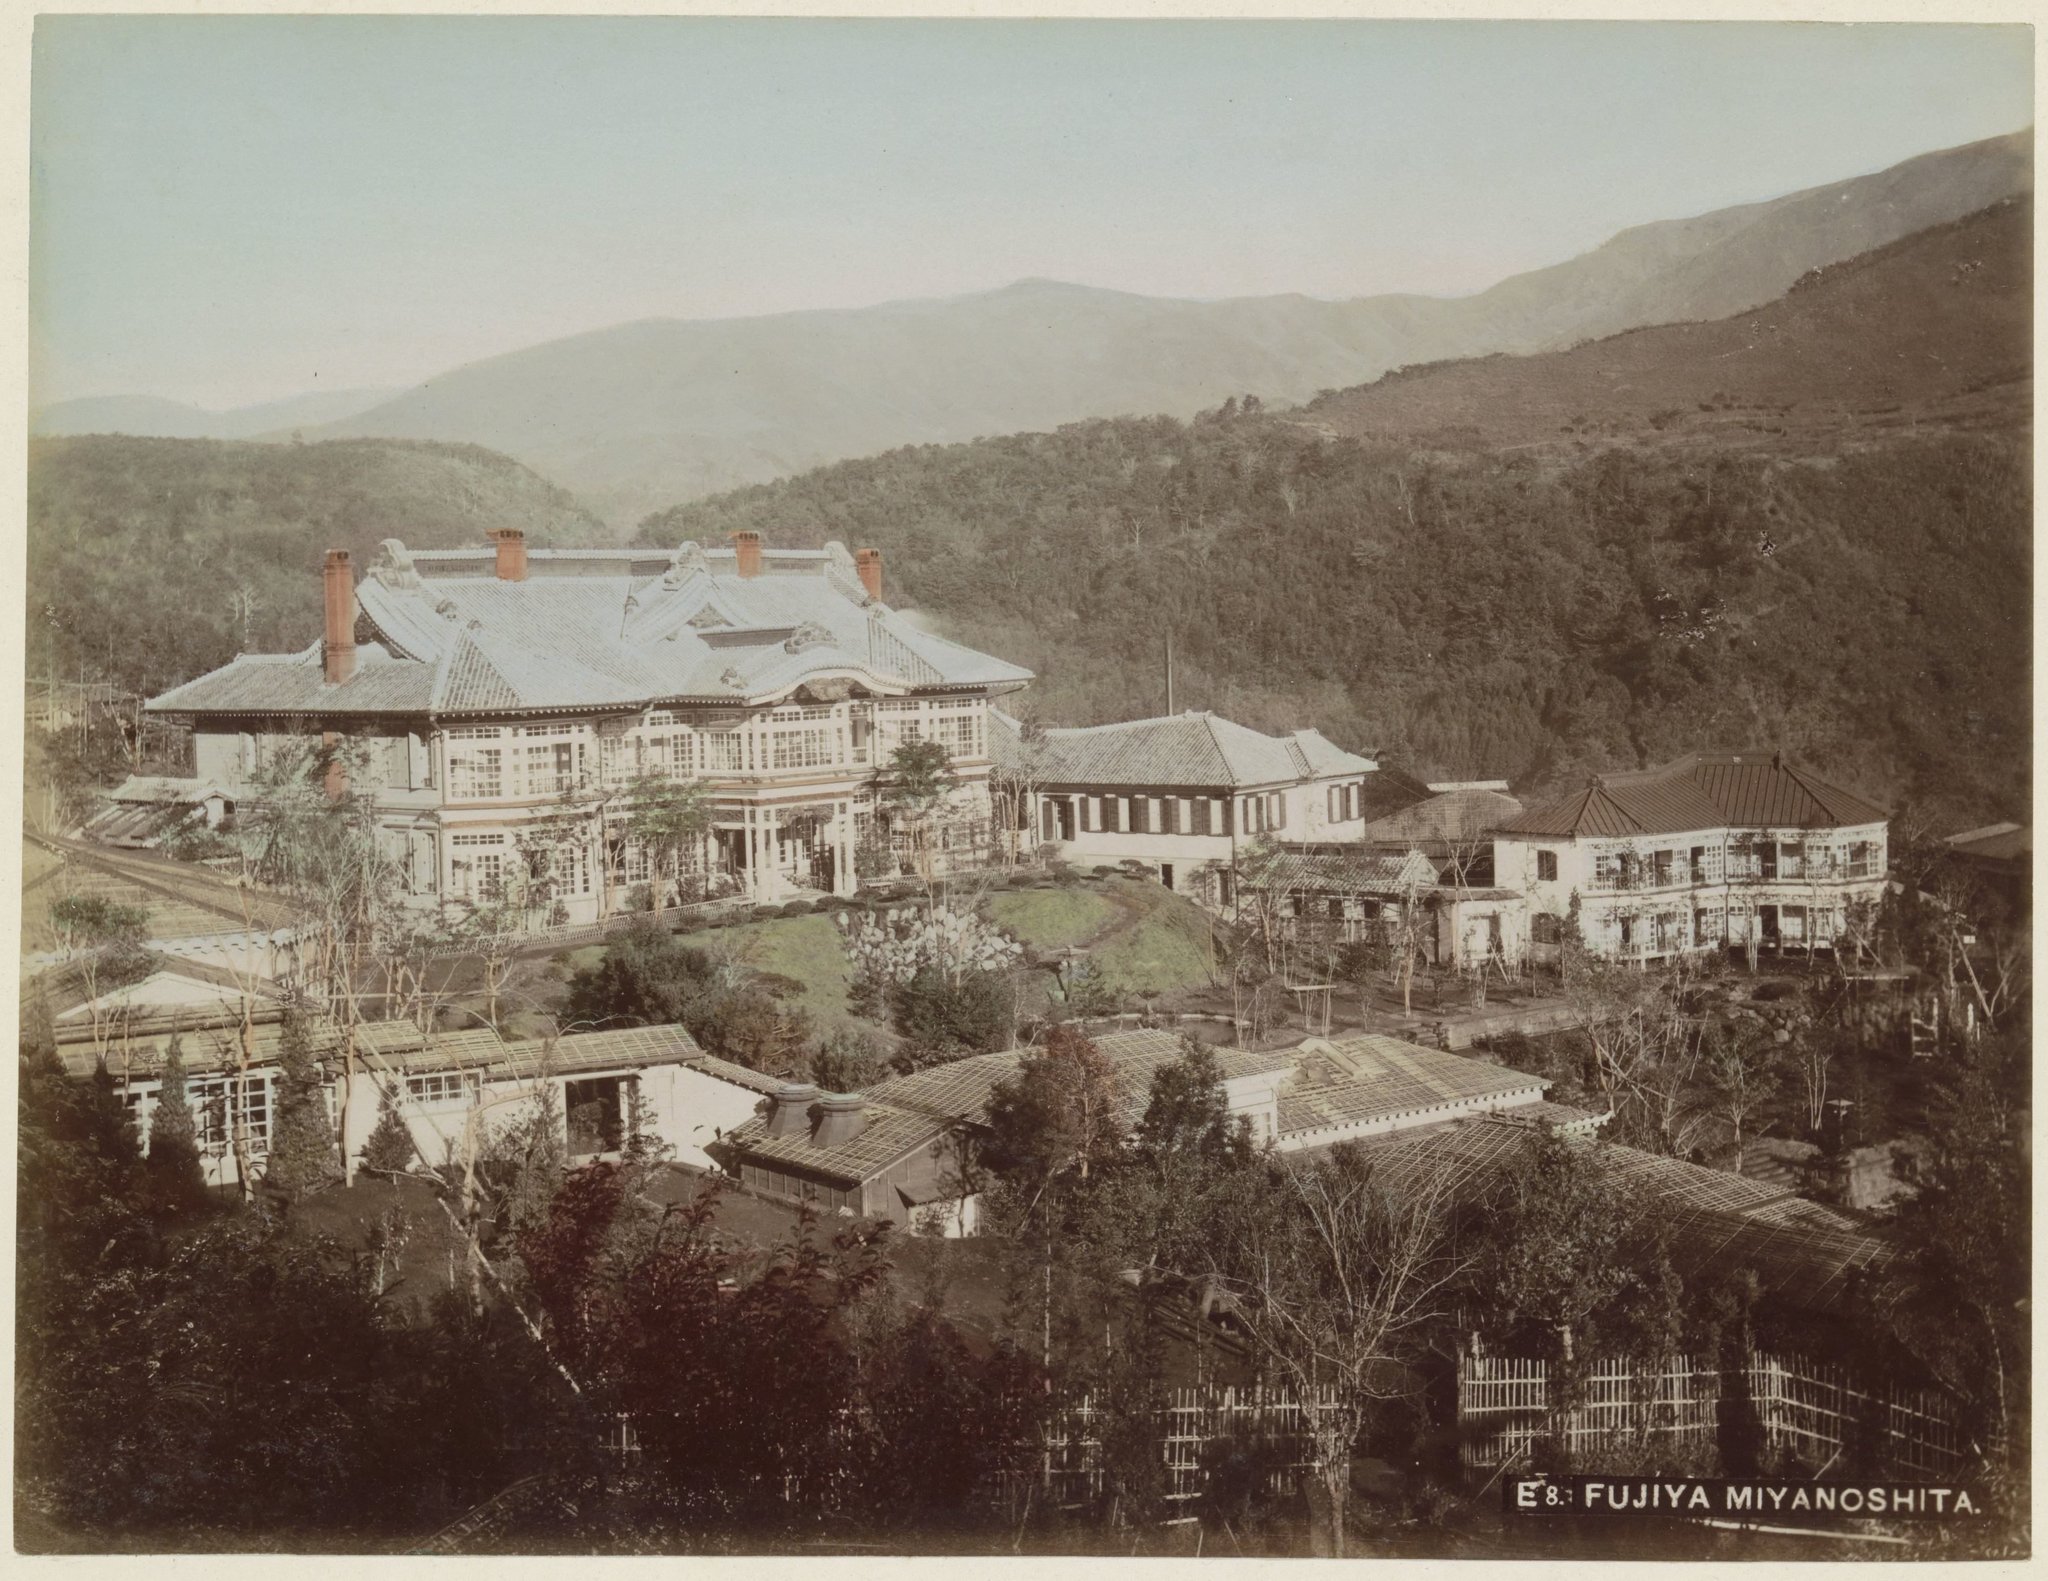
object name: photograph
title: Gezicht op het Fujiya Hotel in Miyanoshita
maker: Anonymous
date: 1891-1900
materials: cardboard, paper, photographic support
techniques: albumen print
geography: miyanoshita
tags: hotel, hostelry, inn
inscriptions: negative number: ‘E8’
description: Onderdeel van Reisalbum met foto's van bezienswaardigheden in Japan.